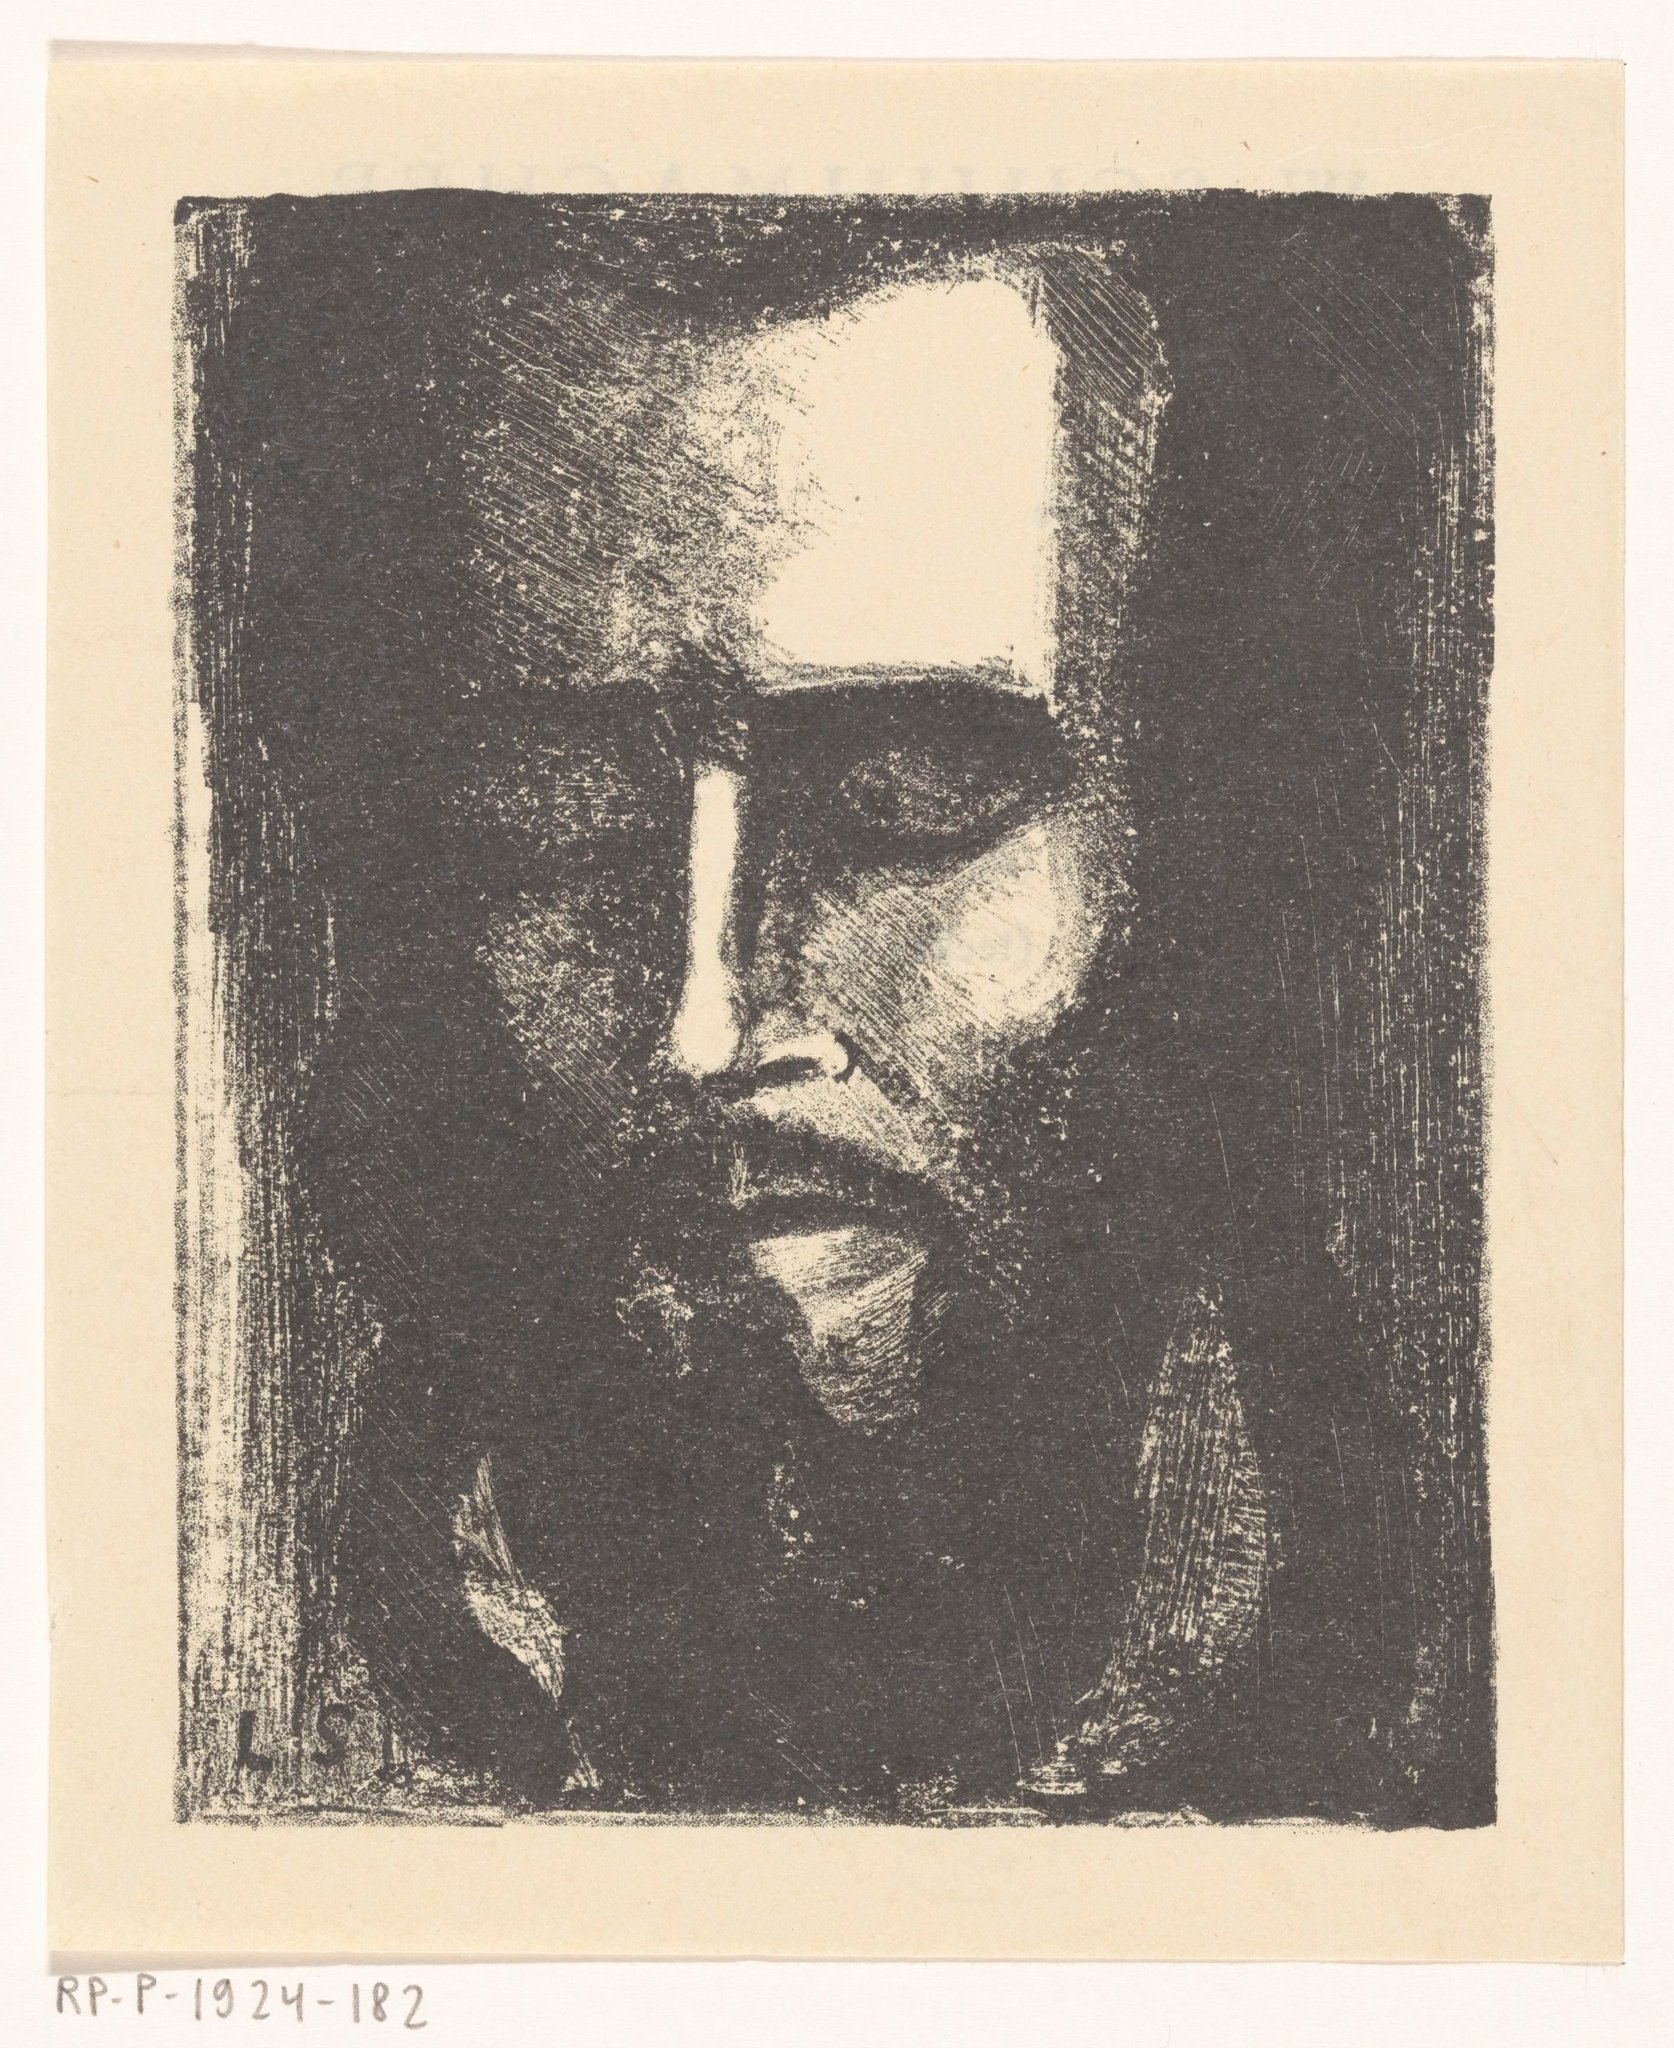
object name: reproduction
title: Reproductie van: Portret van een onbekende man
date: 1921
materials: paper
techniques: printing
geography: hilversum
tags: anonymous historical person portrayed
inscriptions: collector's mark: Lugt 2228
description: Bladzijde afkomstig uit: Catalogus van schilderijen en teekeningen. Tentoongesteld in het Stedelijk Museum Amsterdam. Amsterdam: Hollandsche Kunstenaarskring, 1921.